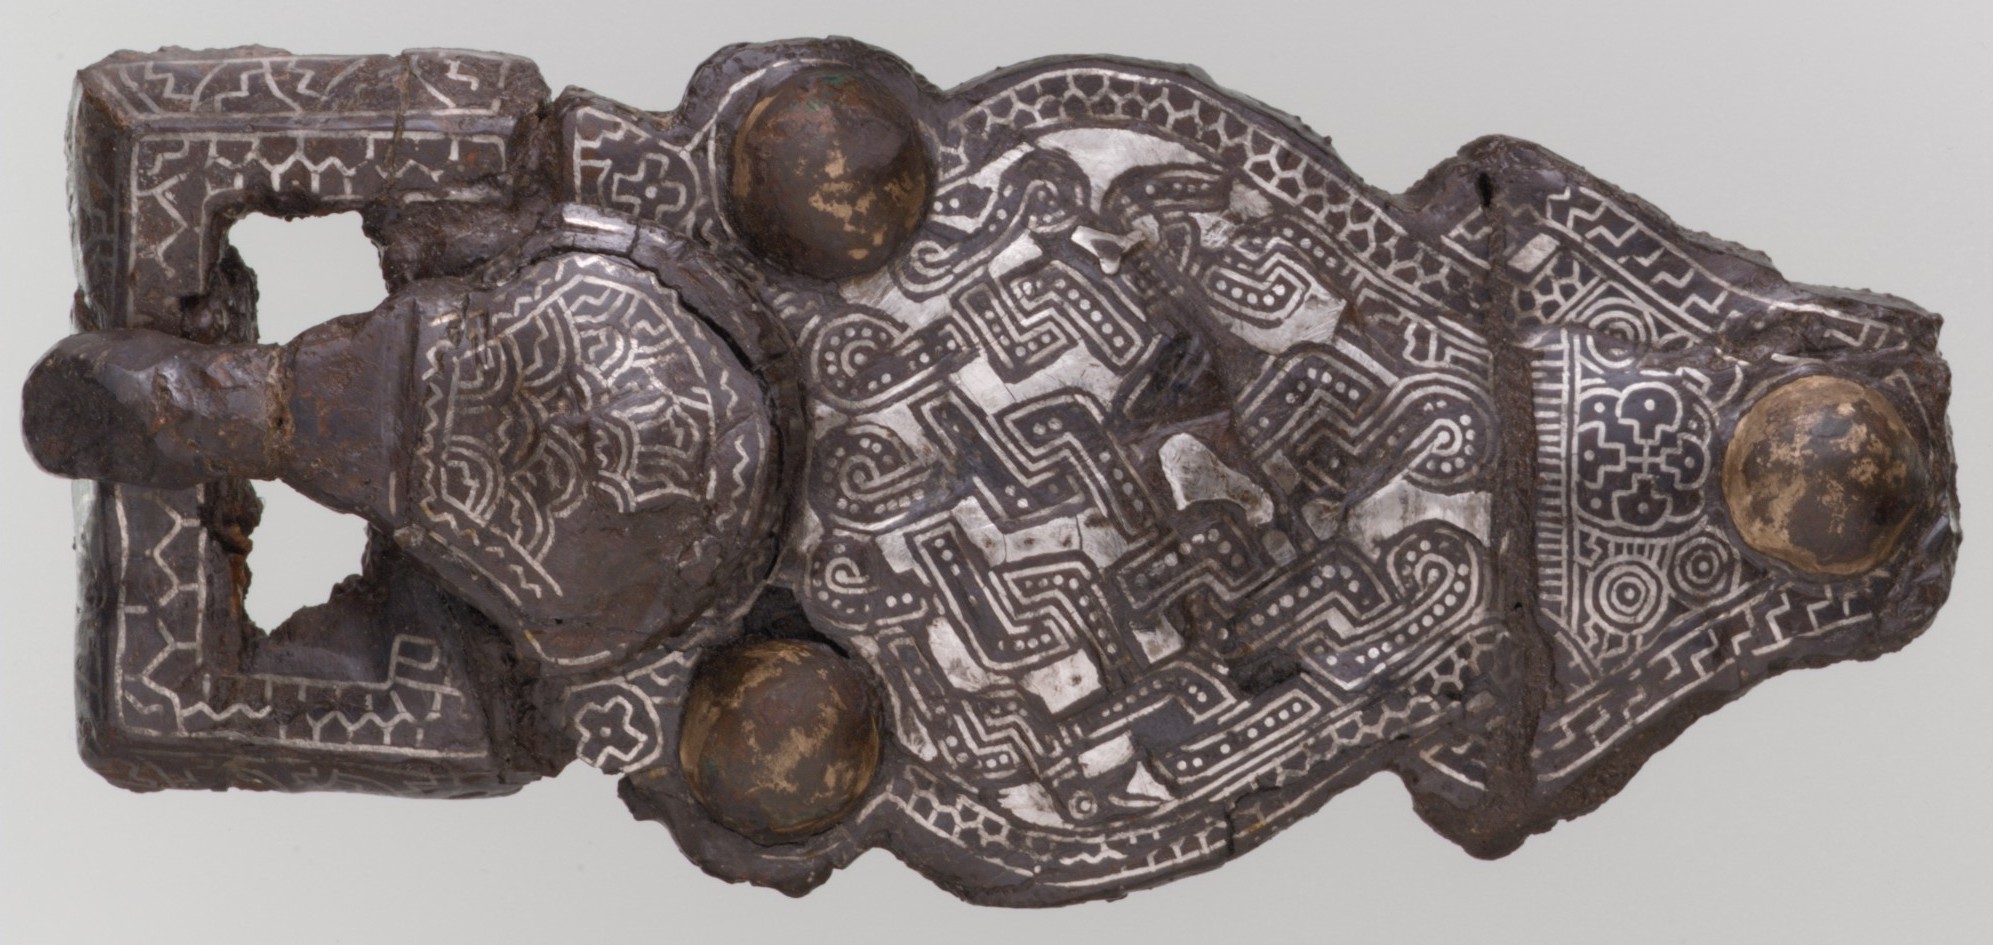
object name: belt buckle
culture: frankish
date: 600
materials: copper alloy, iron, silver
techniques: inlay